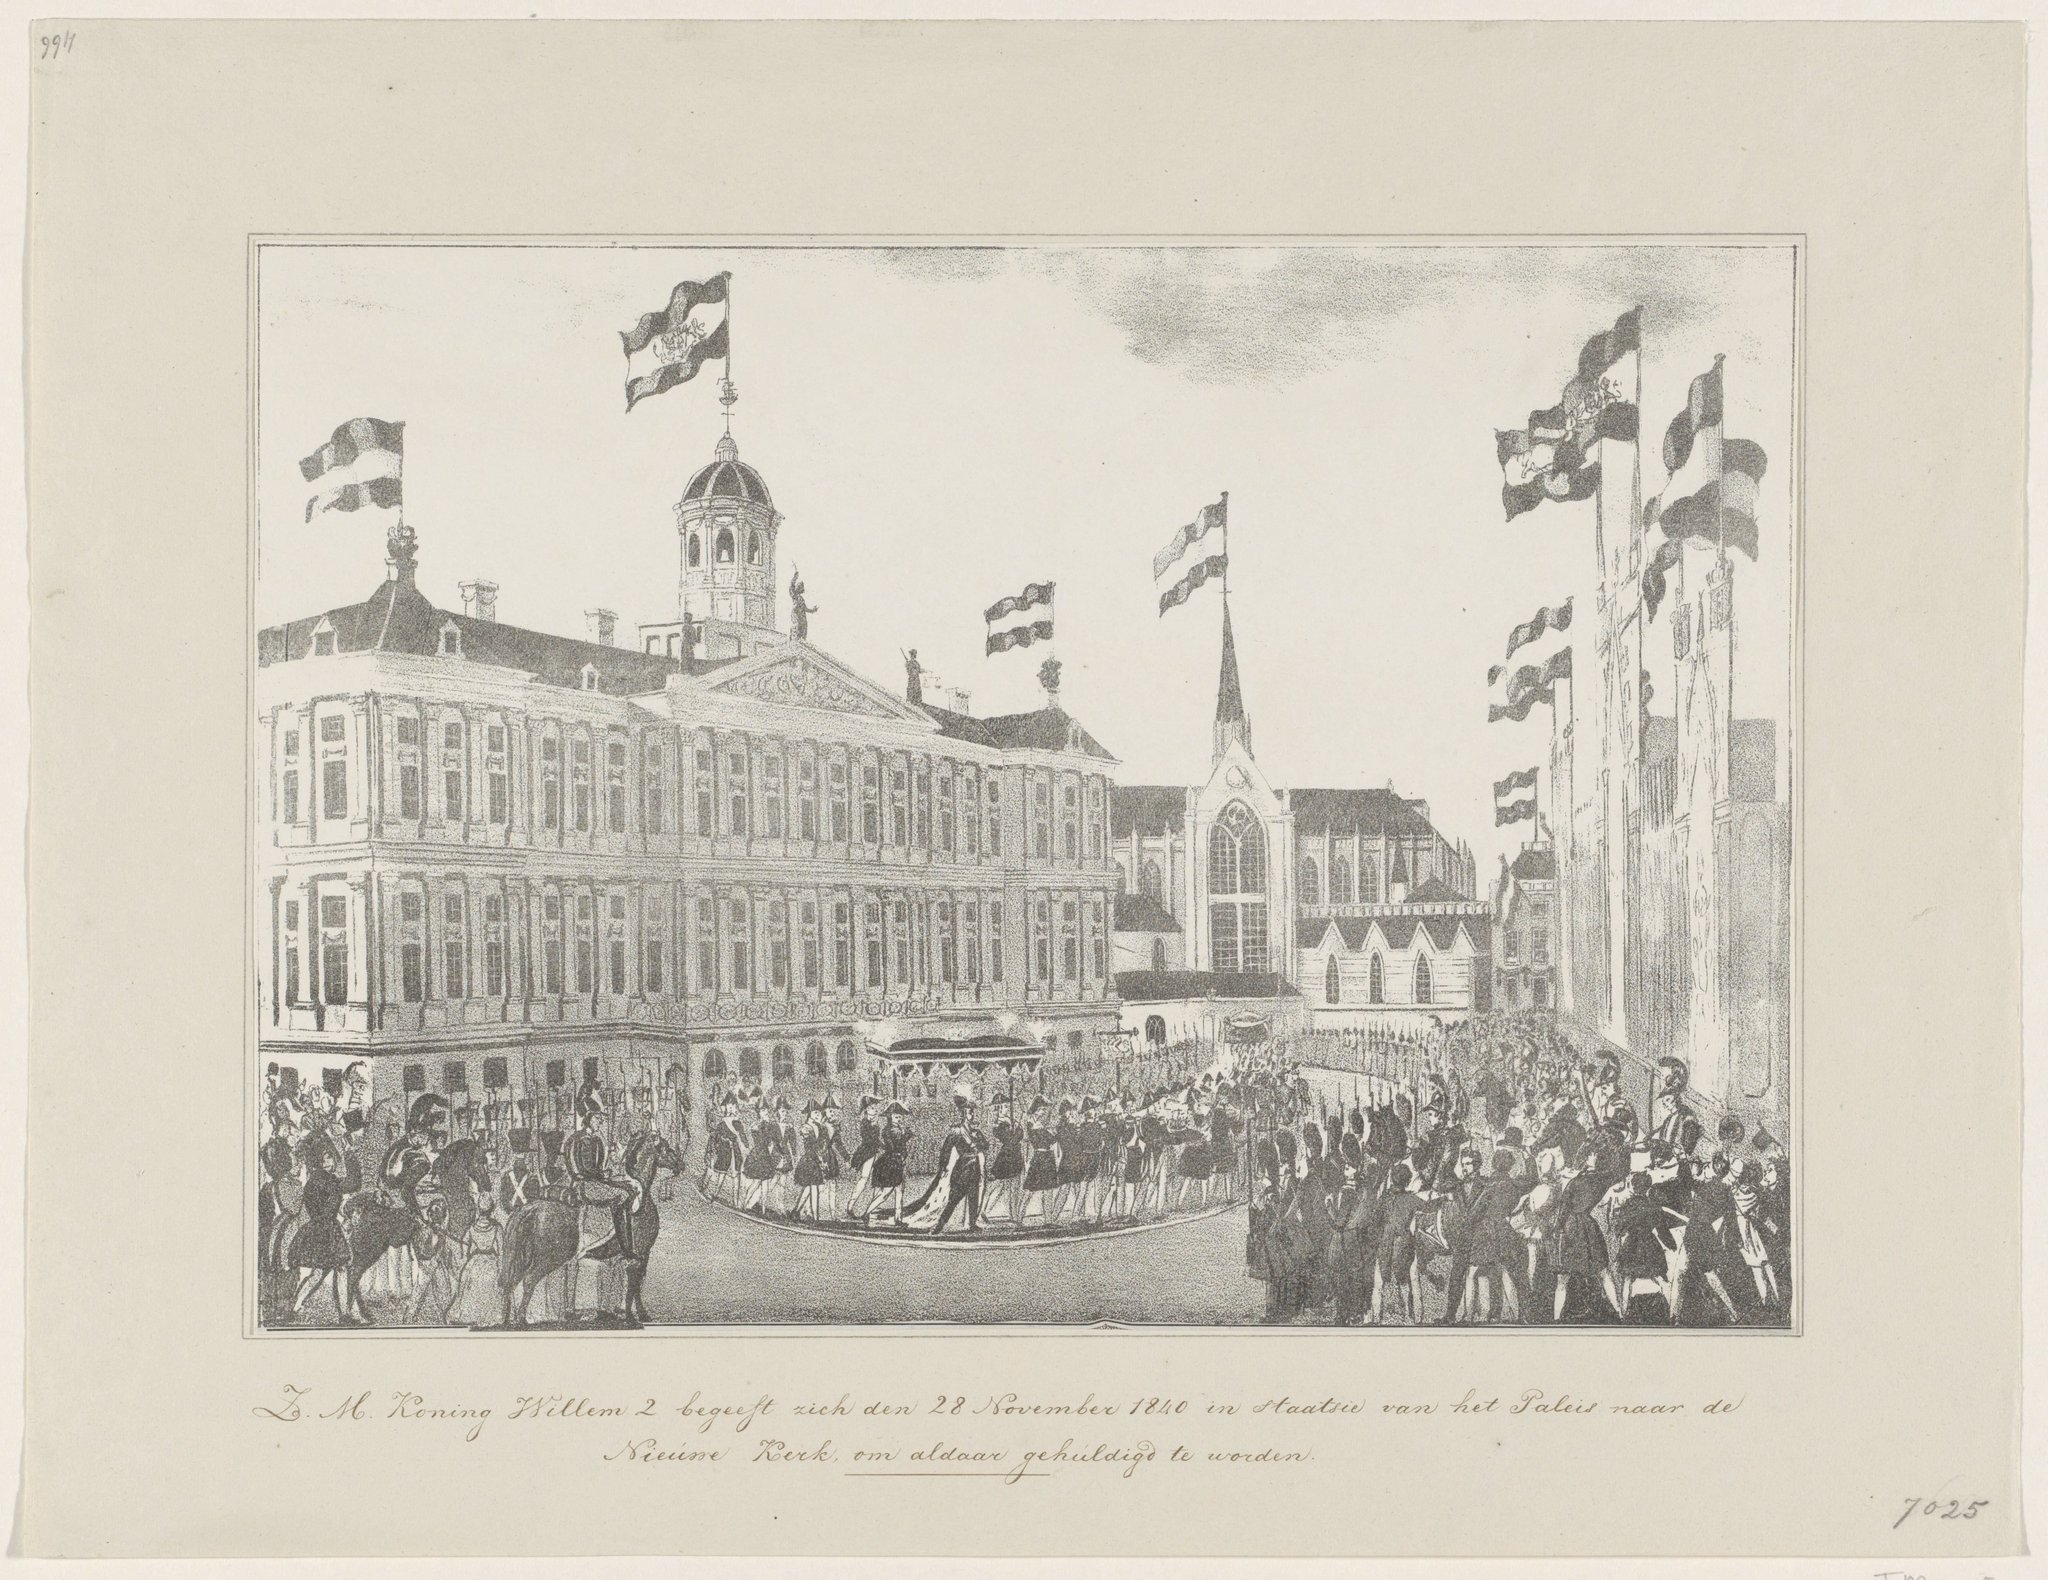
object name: print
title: Z.M. Koning Willem 2 begeeft zich den 28 November 1840 in staatsie van het Paleis naar de Nieuwe Kerk, om aldaar gehuldigd te worden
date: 1840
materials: paper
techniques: lithograph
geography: amsterdam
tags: william ii of the netherlands, other forms of installation, royal palace of amsterdam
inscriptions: collector's mark: Lugt 2228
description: Koning Willem II begeeft zich in een stoet van het Paleis op de Dam naar de Nieuwe Kerk te Amsterdam voor de inhuldiging, 28 november 1840. Rechts een stellage versierd met vlaggen. Zie ook de pendant.